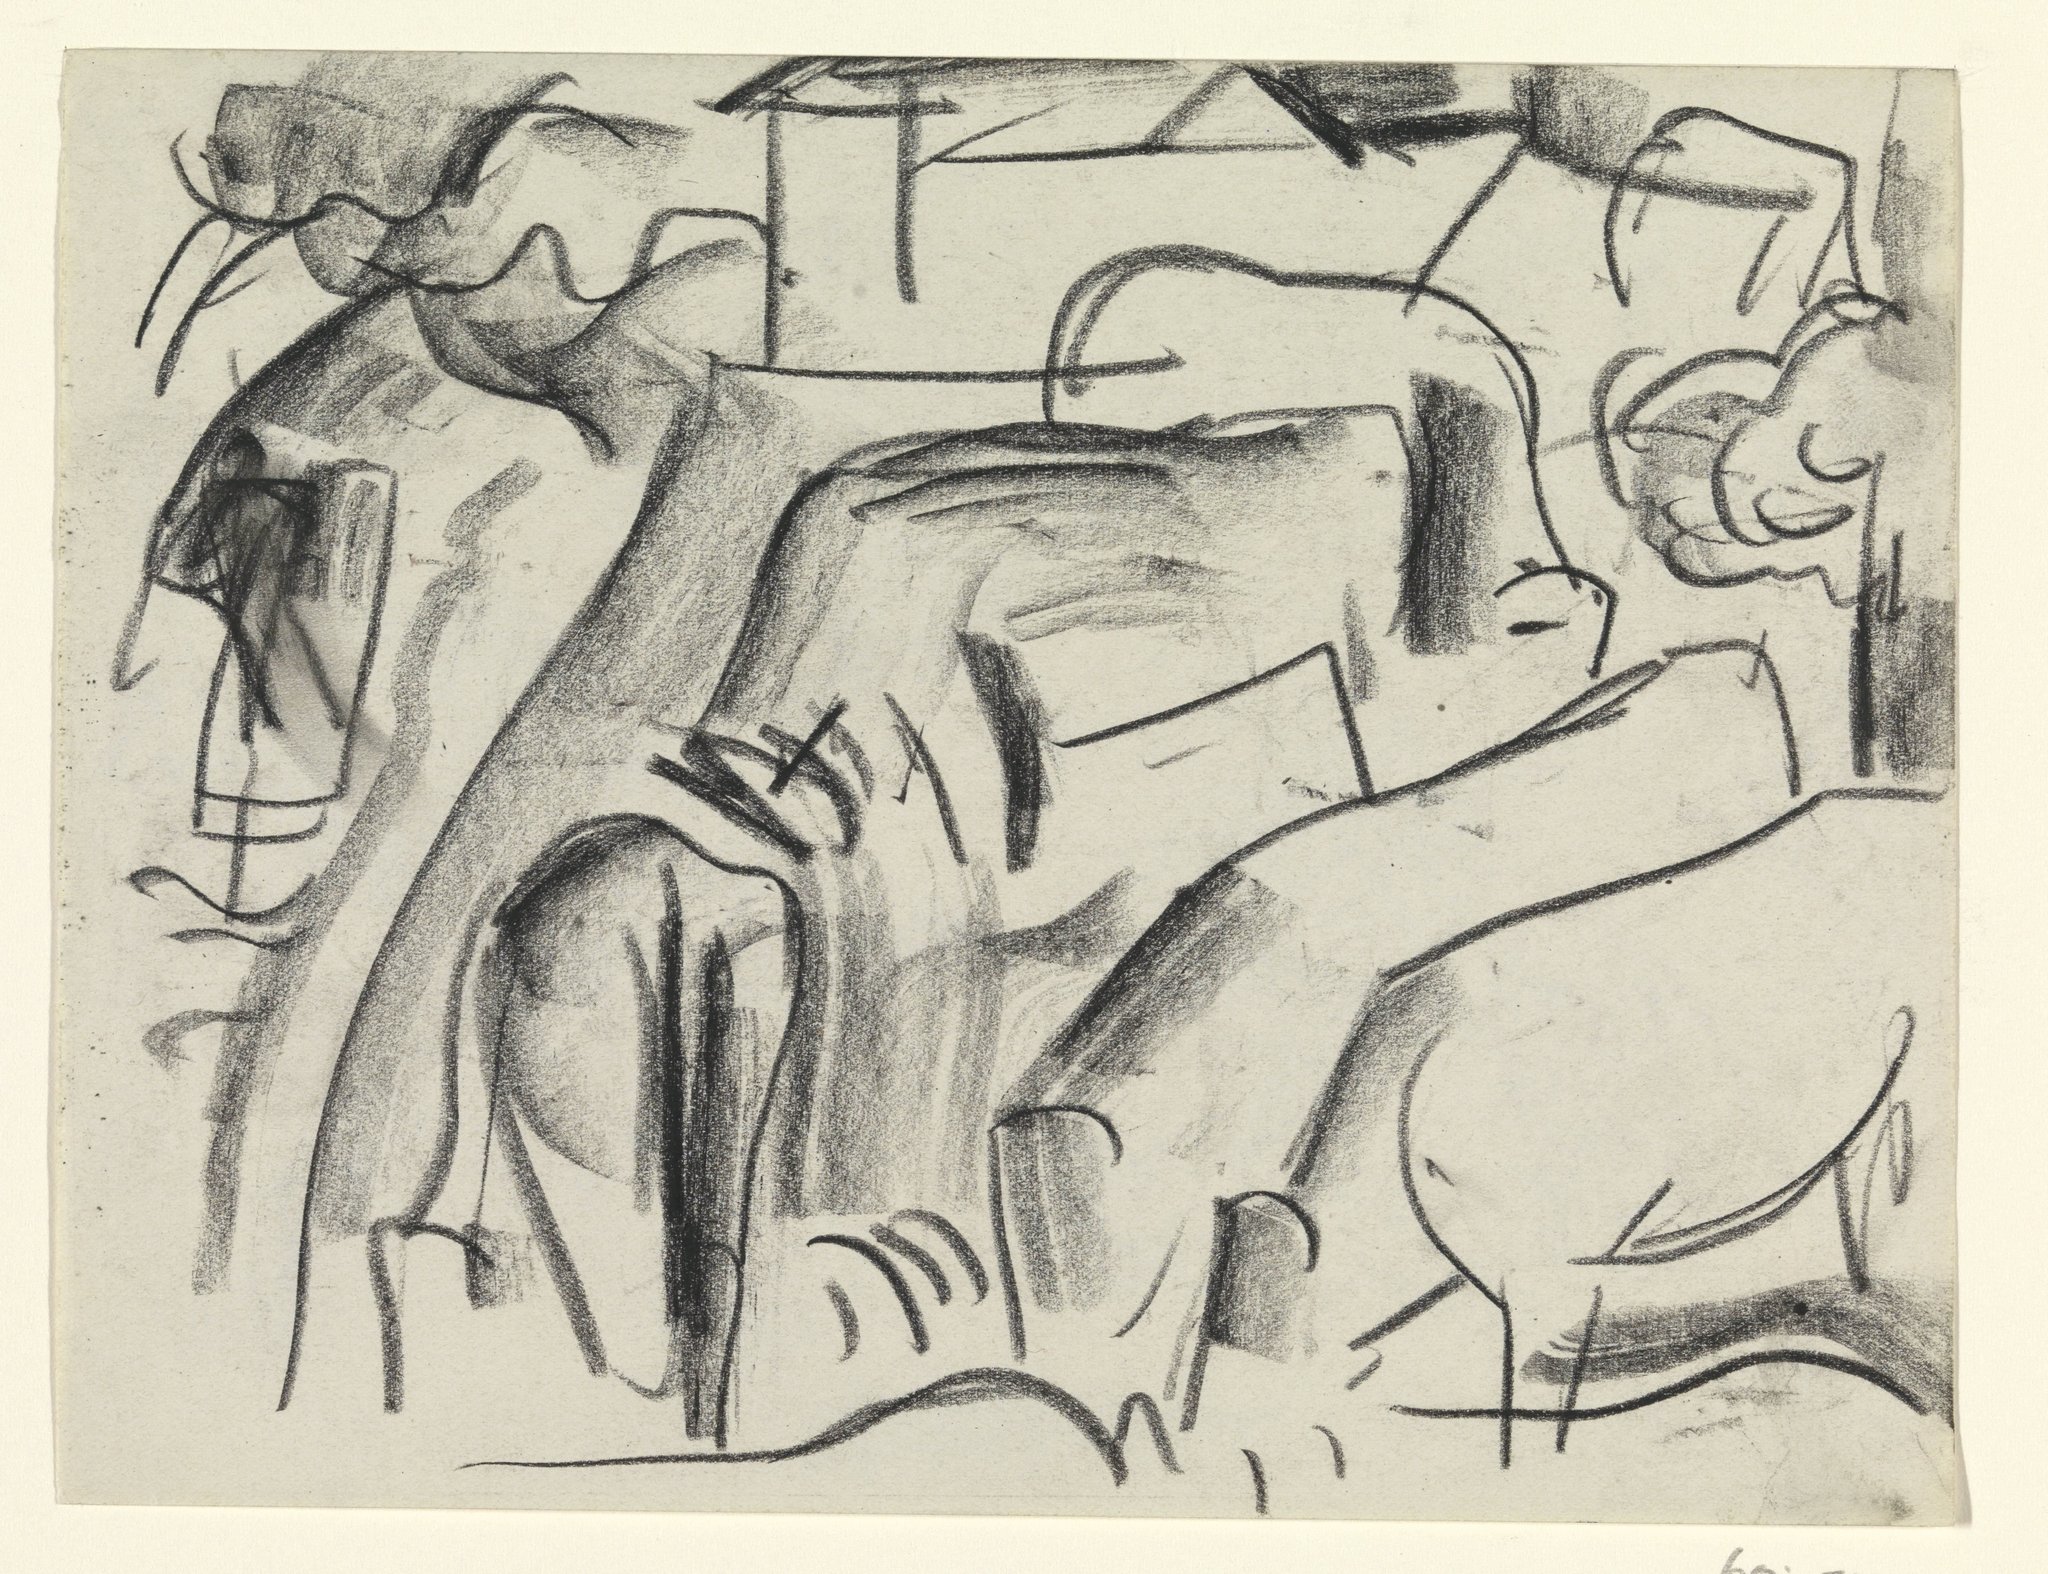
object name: drawing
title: Koeien en paarden bij een boerderij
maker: leo gestel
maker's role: draughtsman, print maker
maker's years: 1881-1941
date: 1891-1941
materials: chalk, paper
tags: cow, horse, farm or solitary house in landscape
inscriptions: collector's mark: Lugt 2228